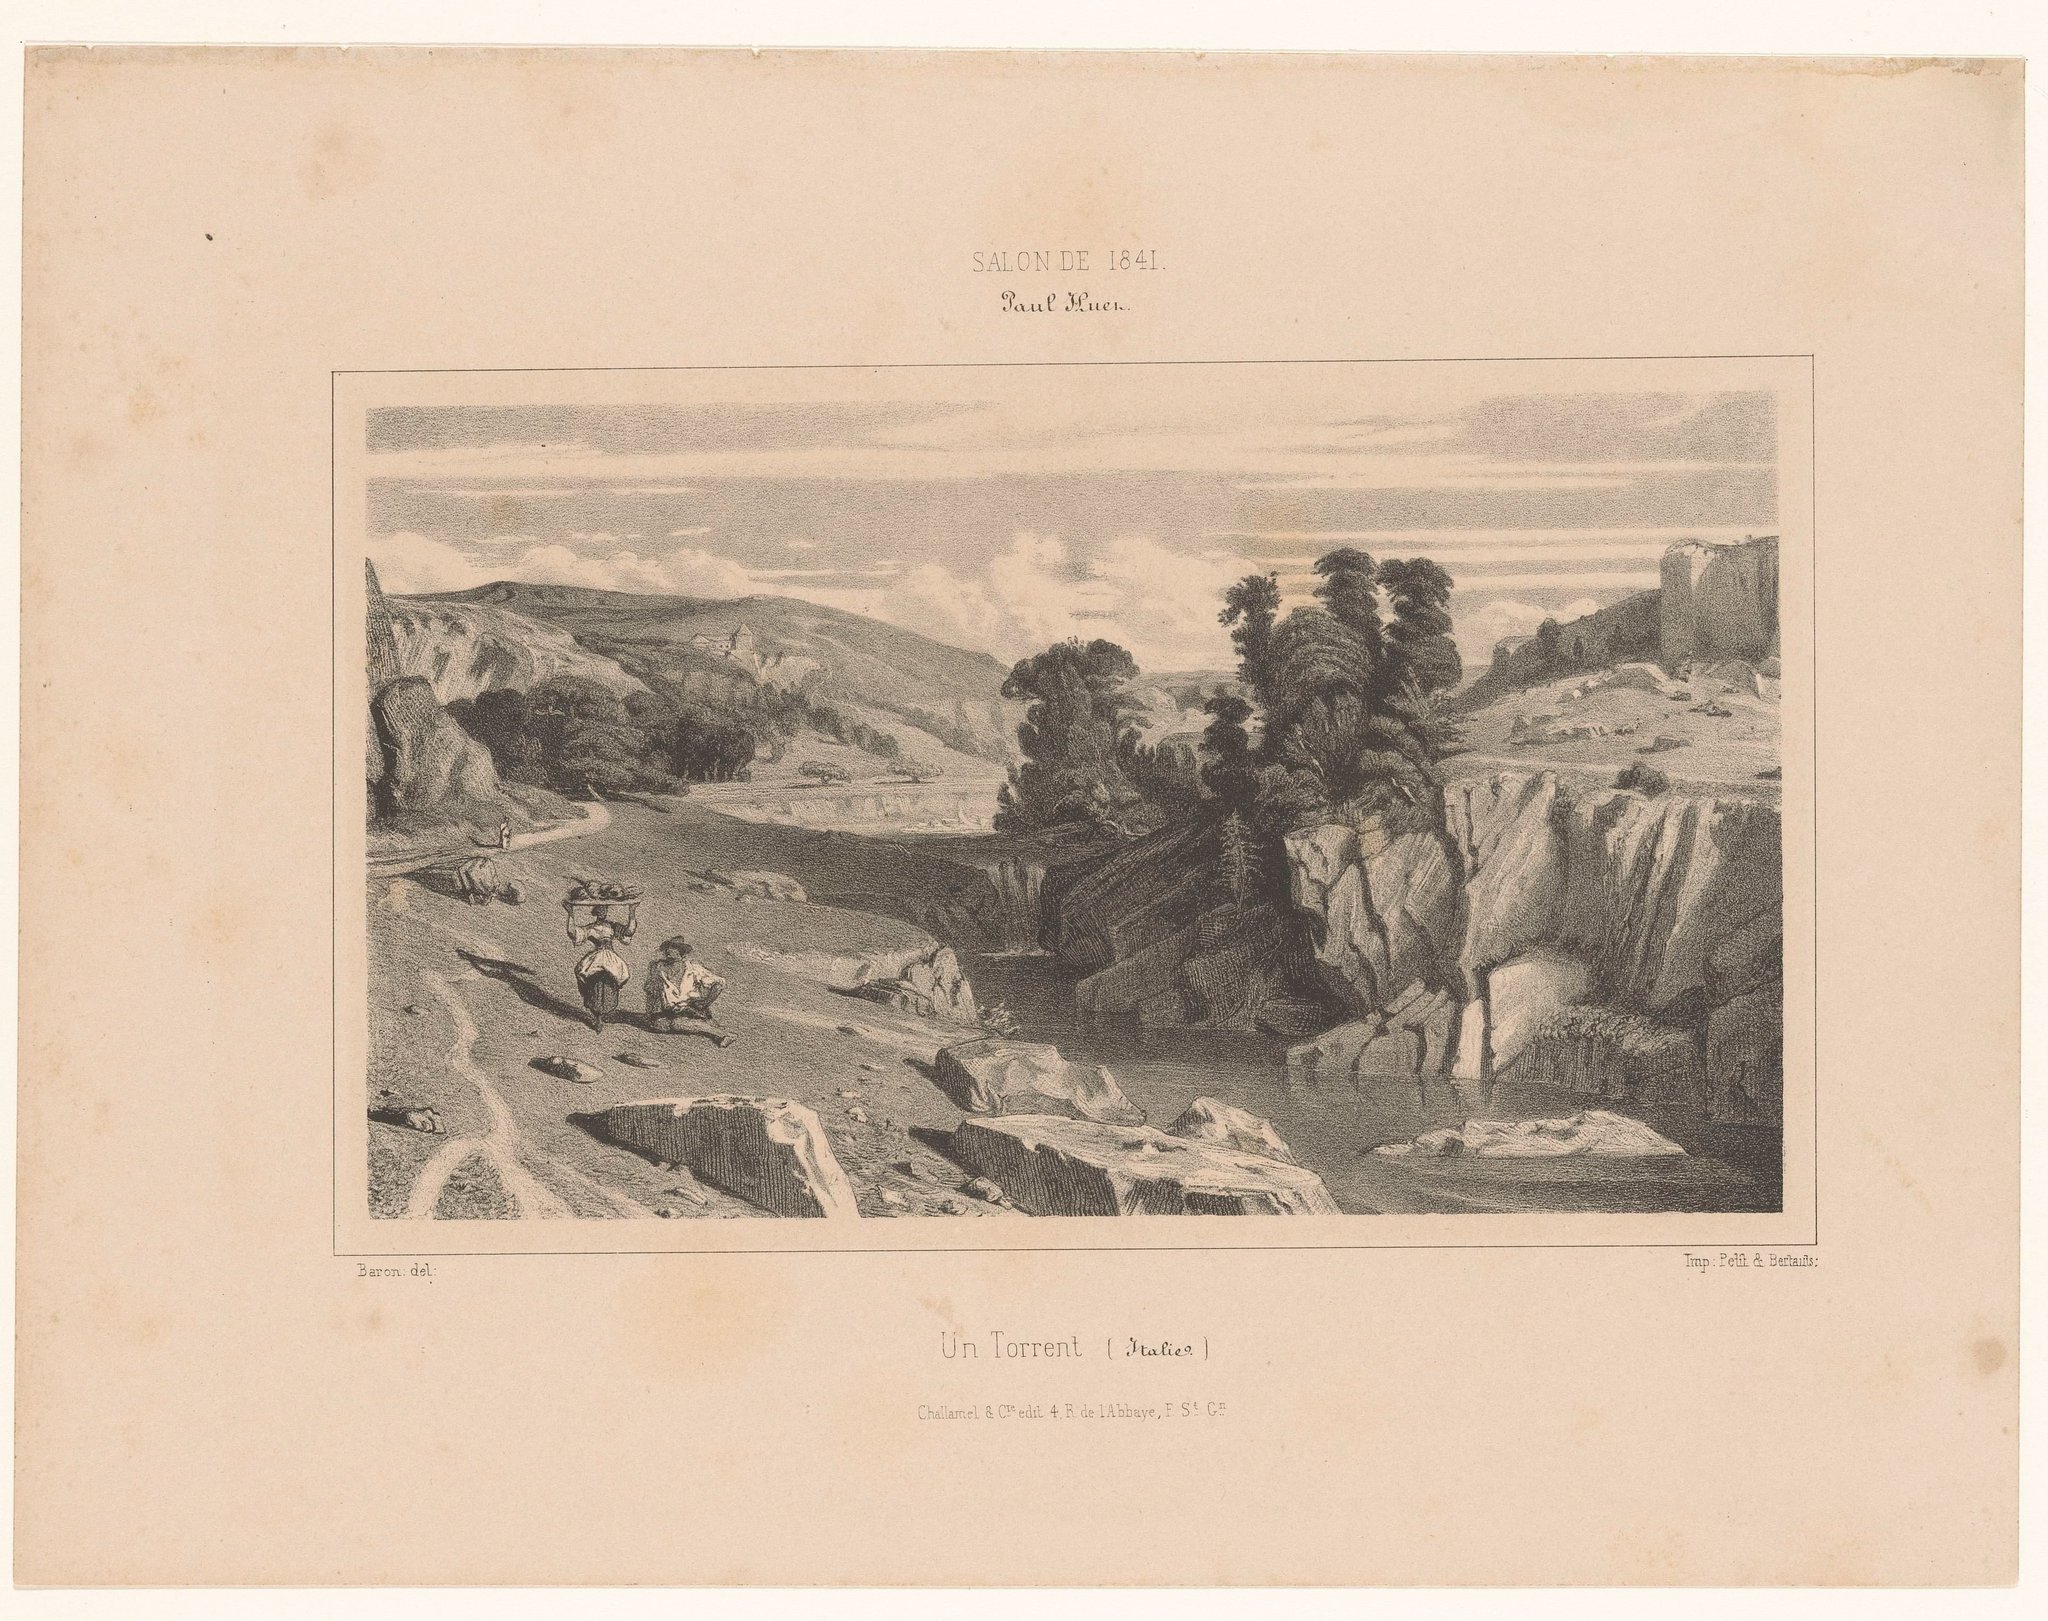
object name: print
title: Italiaans landschap met bergbeek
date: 1841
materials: paper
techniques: lithograph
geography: paris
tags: low hill country (+ landscape with figures, staffage), brook (+ landscape with figures, staffage), italy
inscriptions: collector's mark: Lugt 2228a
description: Prent gebruikt in: Ténint, Wilhelm. Album du Salon de 1841. Collection des principaux ouvrages exposés au Louvre (…). Parijs: Augustin Challamel, 1841.